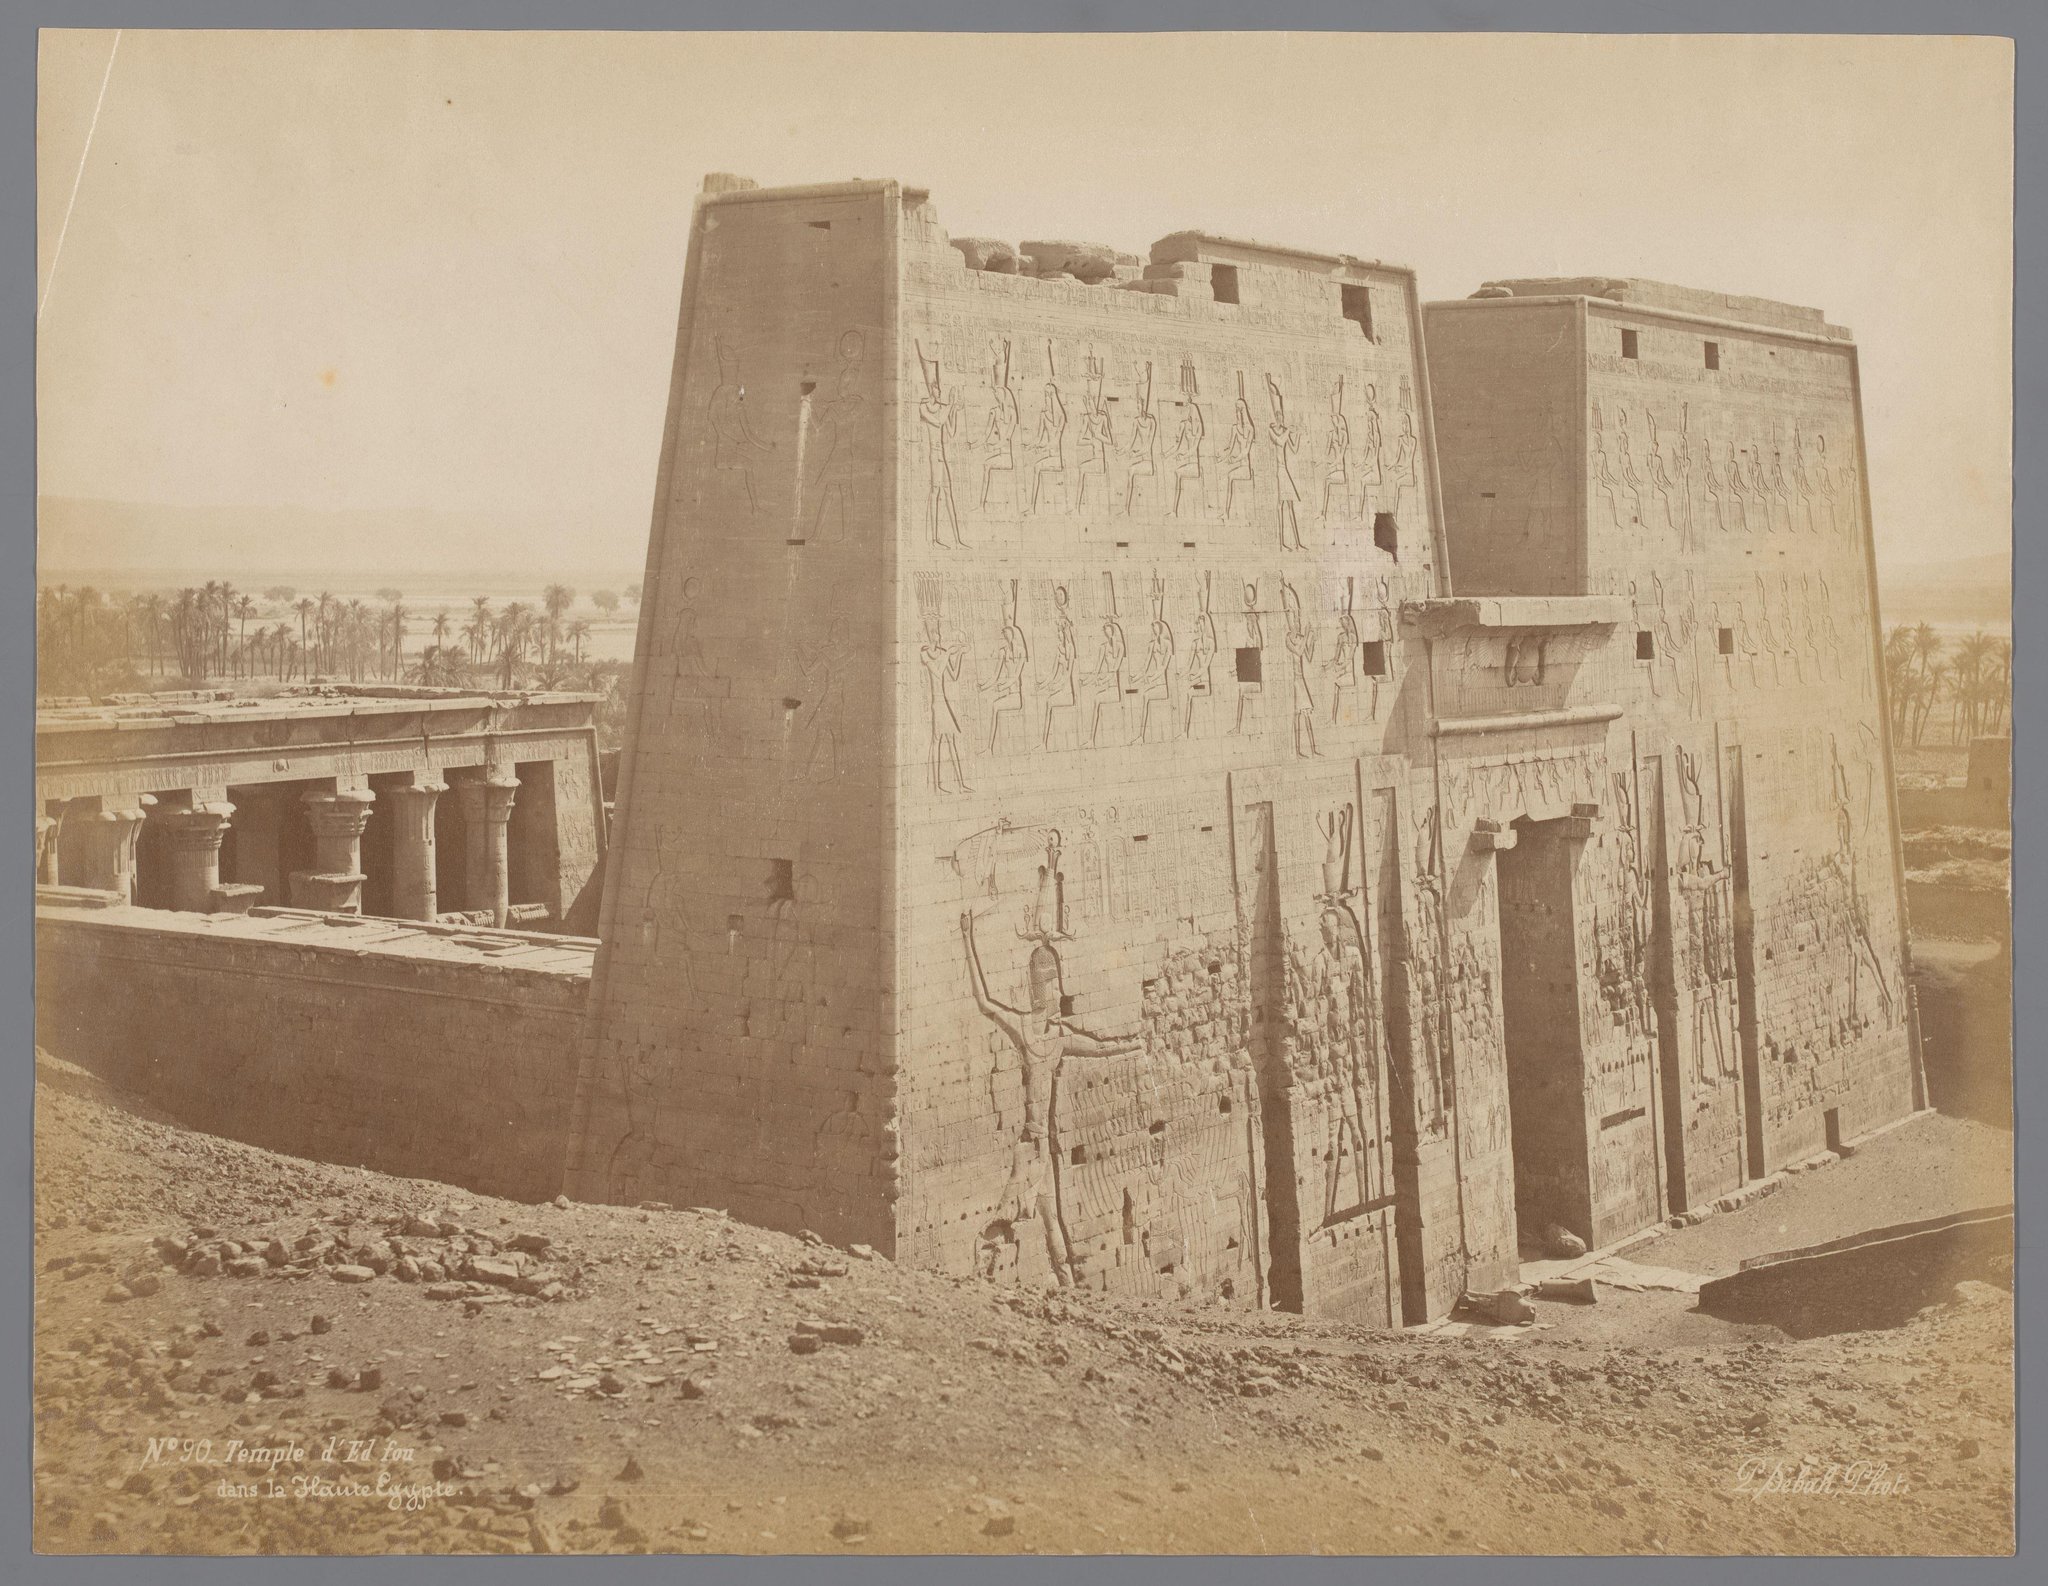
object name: photograph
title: Tempel in Opper-Egypte ["Temple d'Ed fou dans la Houte-Egypte."]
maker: pascal sébah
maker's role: fotograaf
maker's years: 1823-1886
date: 1870-1900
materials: paper, photographic support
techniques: albumen print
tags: egypte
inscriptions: inscription: ‘No. 90 Temple d'Ed fou//dans la Haute Egypte.’, inscription: ‘P. Sebah Phot,’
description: Opper-Egypte was het zuidelijke deel van het Oude Egypte dat zich uitstrekte vanaf het huidige Caïro tot aan de eerste cataract van de Nijl (hoewel de grens soms meer naar het zuiden werd verschoven). Op de tegenwoordige kaarten van Egypte ligt het gebied van het toenmalige Opper-Egypte in het zuiden, in tegenstelling tot wat de naam doet vermoeden.